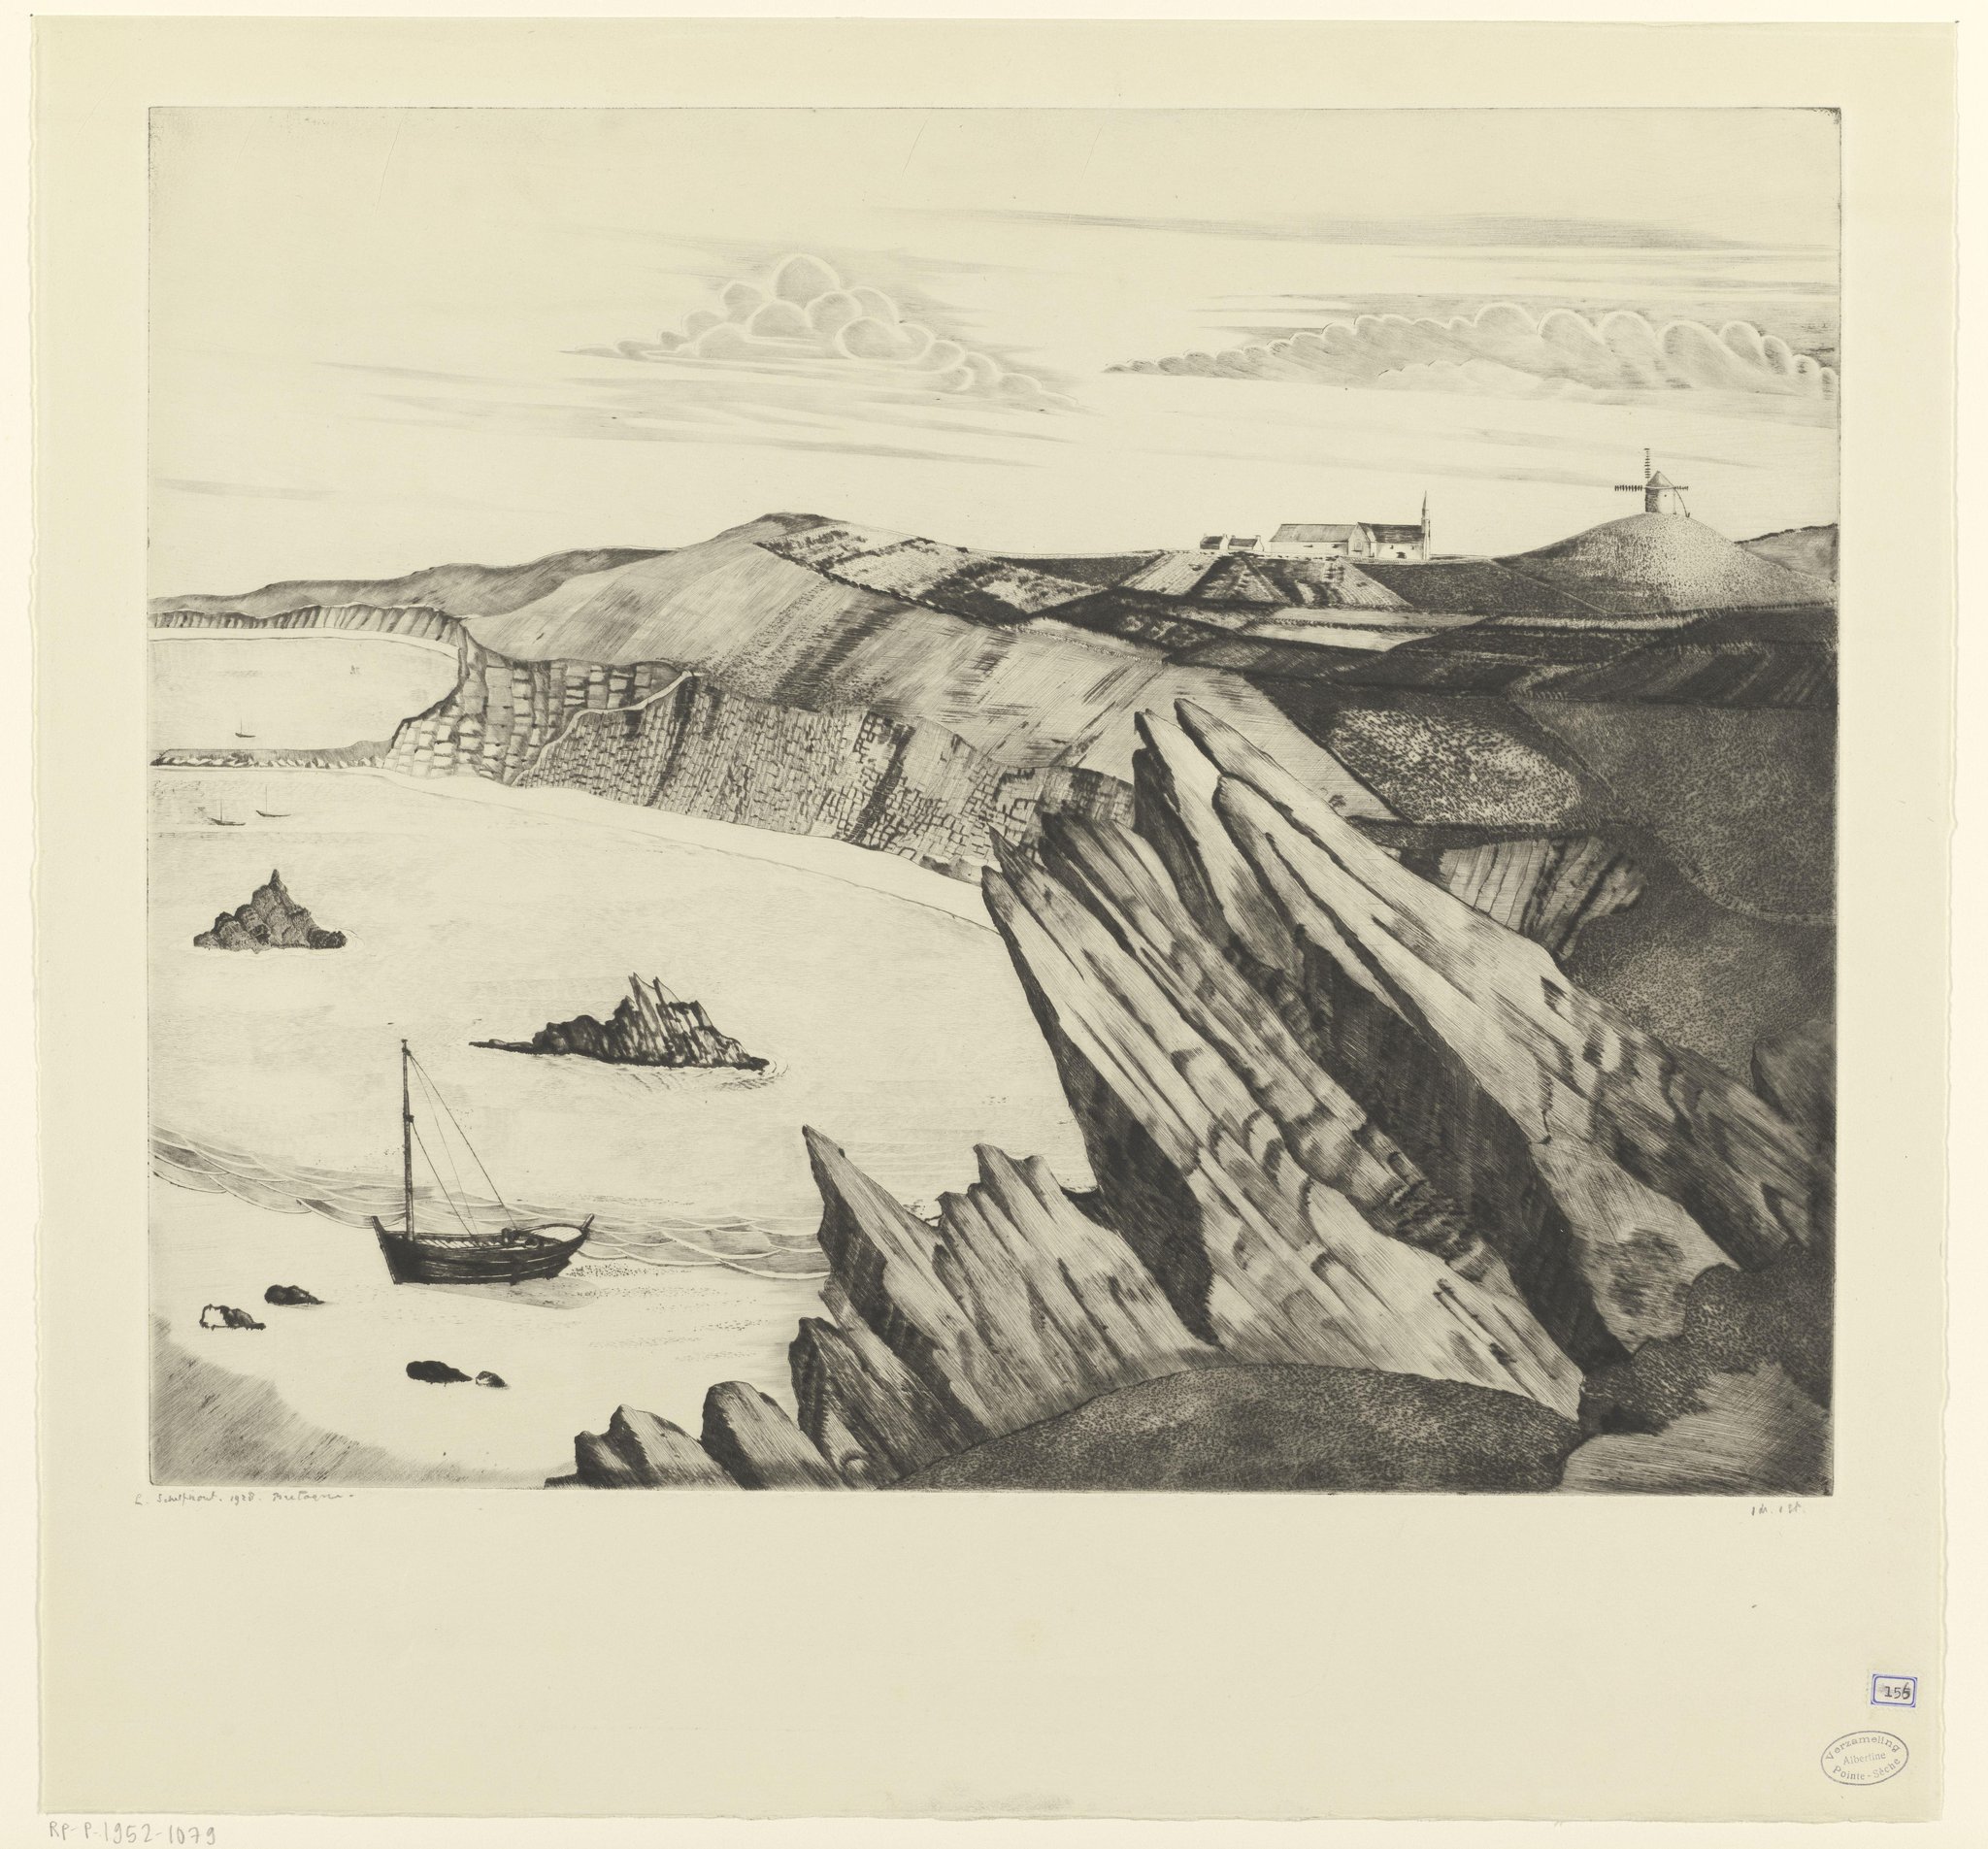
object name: print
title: La Bretagne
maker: lodewijk schelfhout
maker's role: draughtsman, print maker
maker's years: 1881-1943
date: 1928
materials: paper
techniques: drypoint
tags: prospect of village, silhouette of village, rocky coast, ships (in general)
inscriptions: collector's mark: Lugt 2228, collector's mark: Lugt 5i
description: Links op de voorgrond een afgemeerd schip op het strand. Rechts op de achtergrond een nederzetting met kerk en molen.